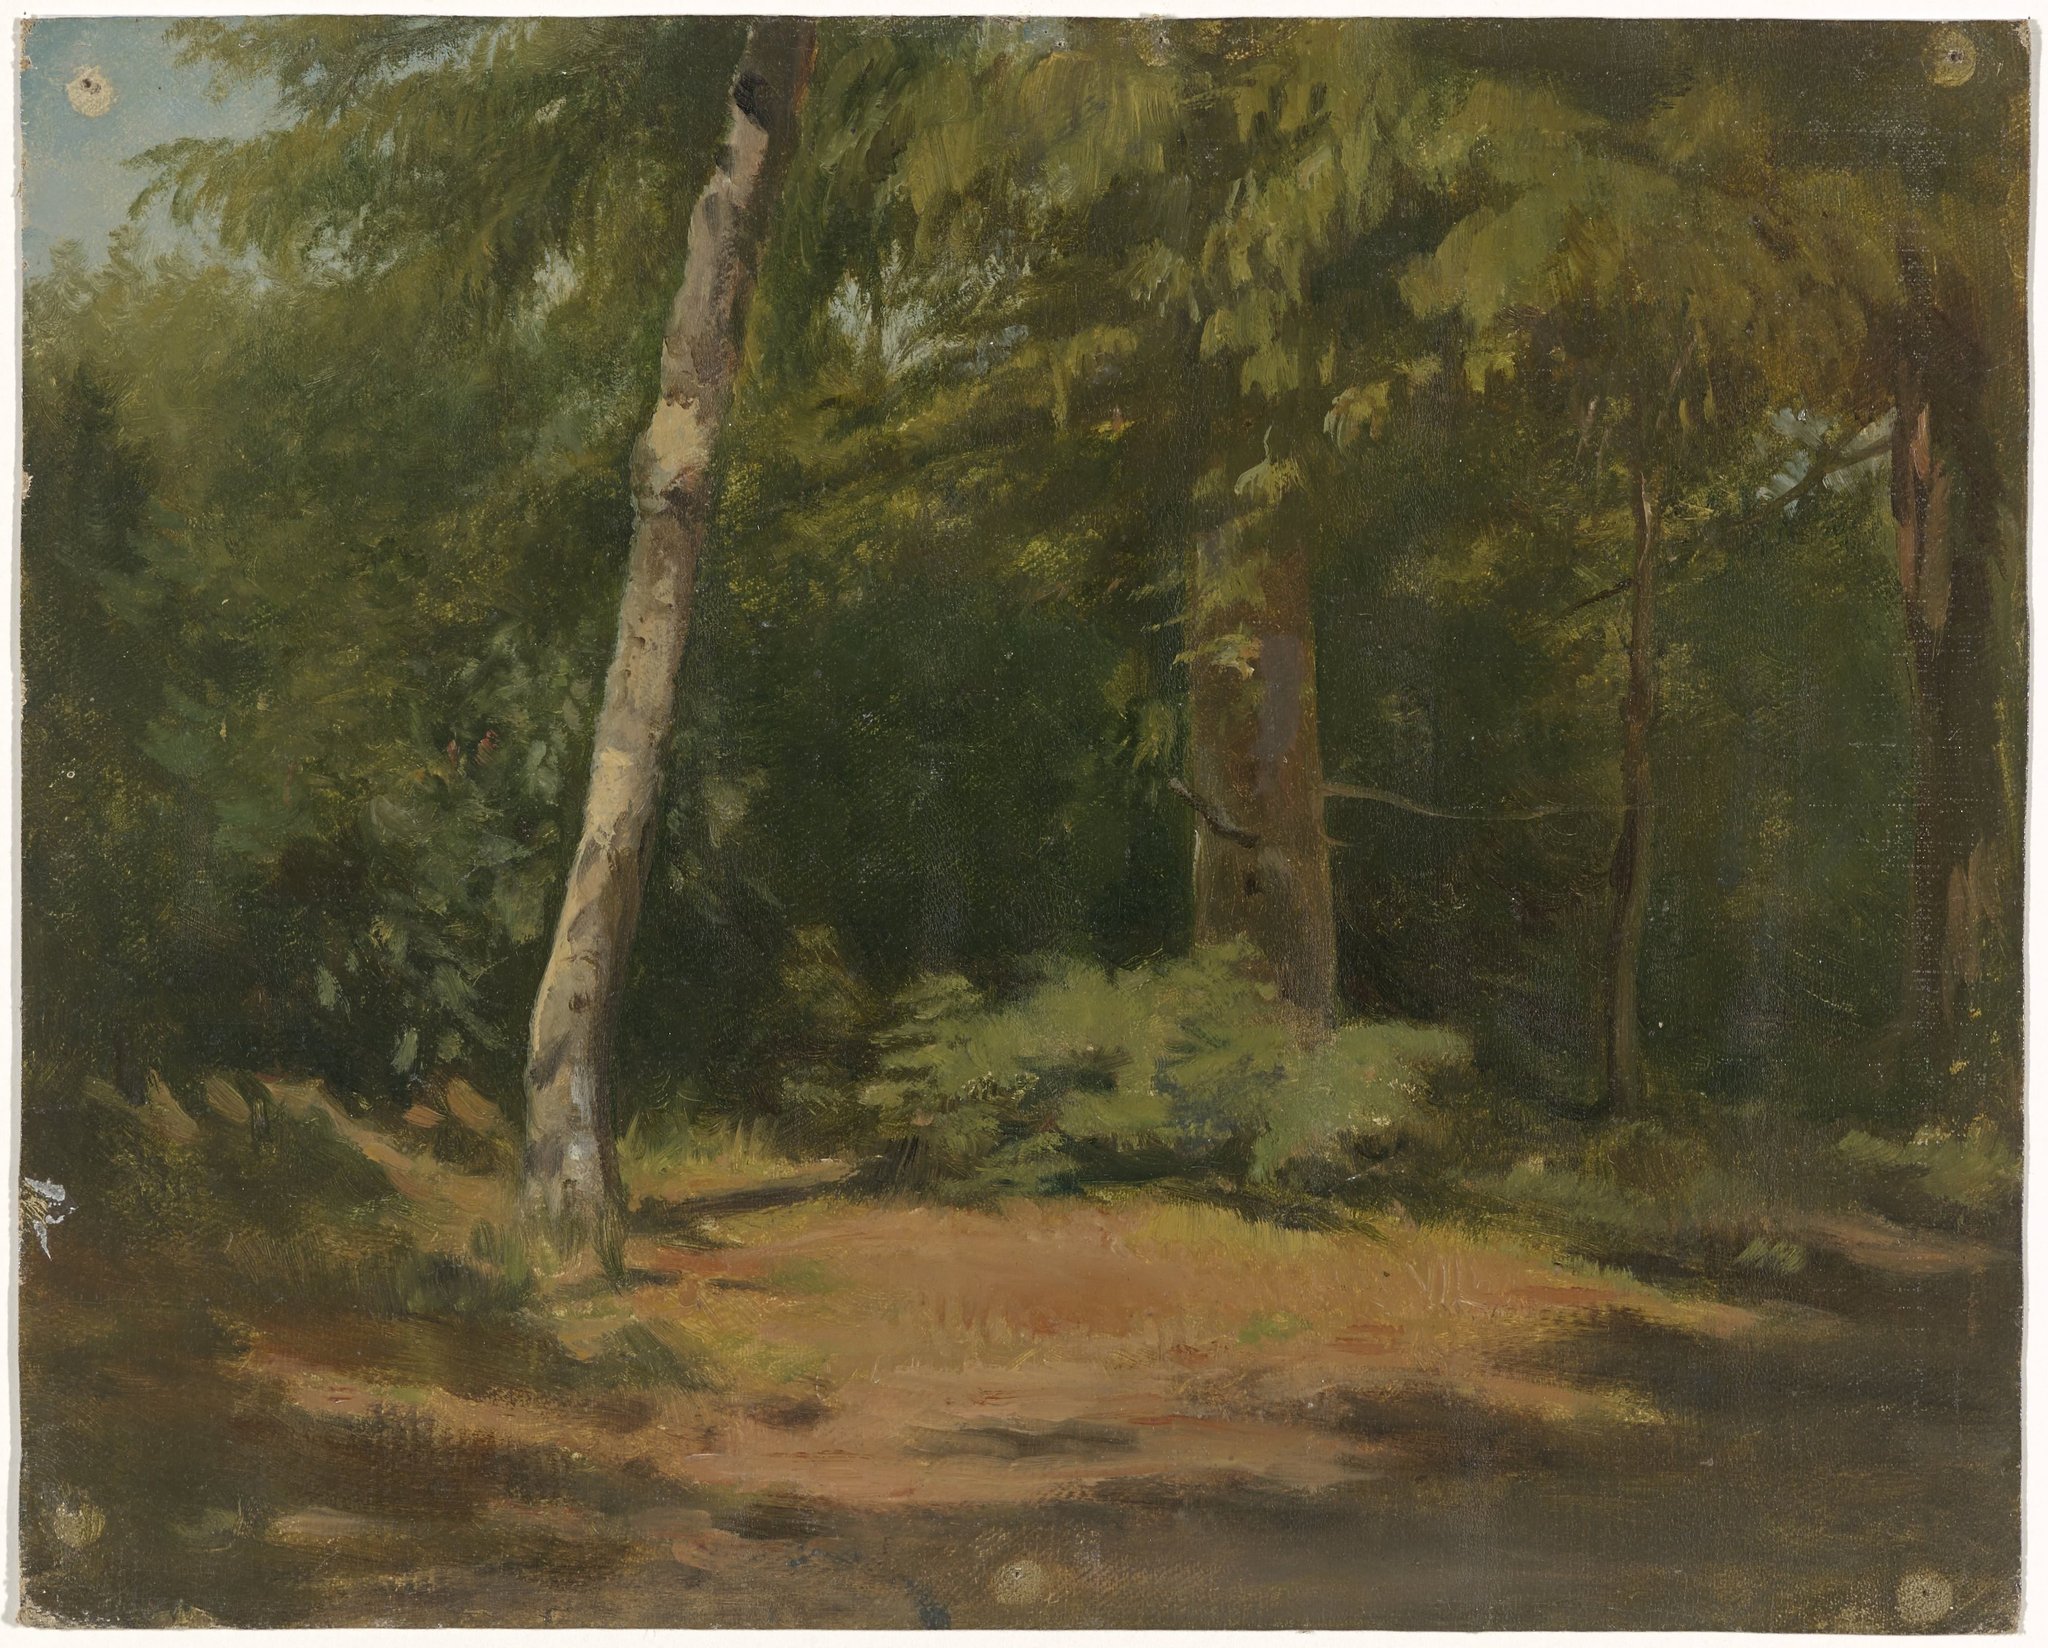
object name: oil sketch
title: Open plek in het bos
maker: guillaume anne van der brugghen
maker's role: draughtsman, print maker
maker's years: 1812-1891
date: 1821-1891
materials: linen, oil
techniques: brush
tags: forest, wood